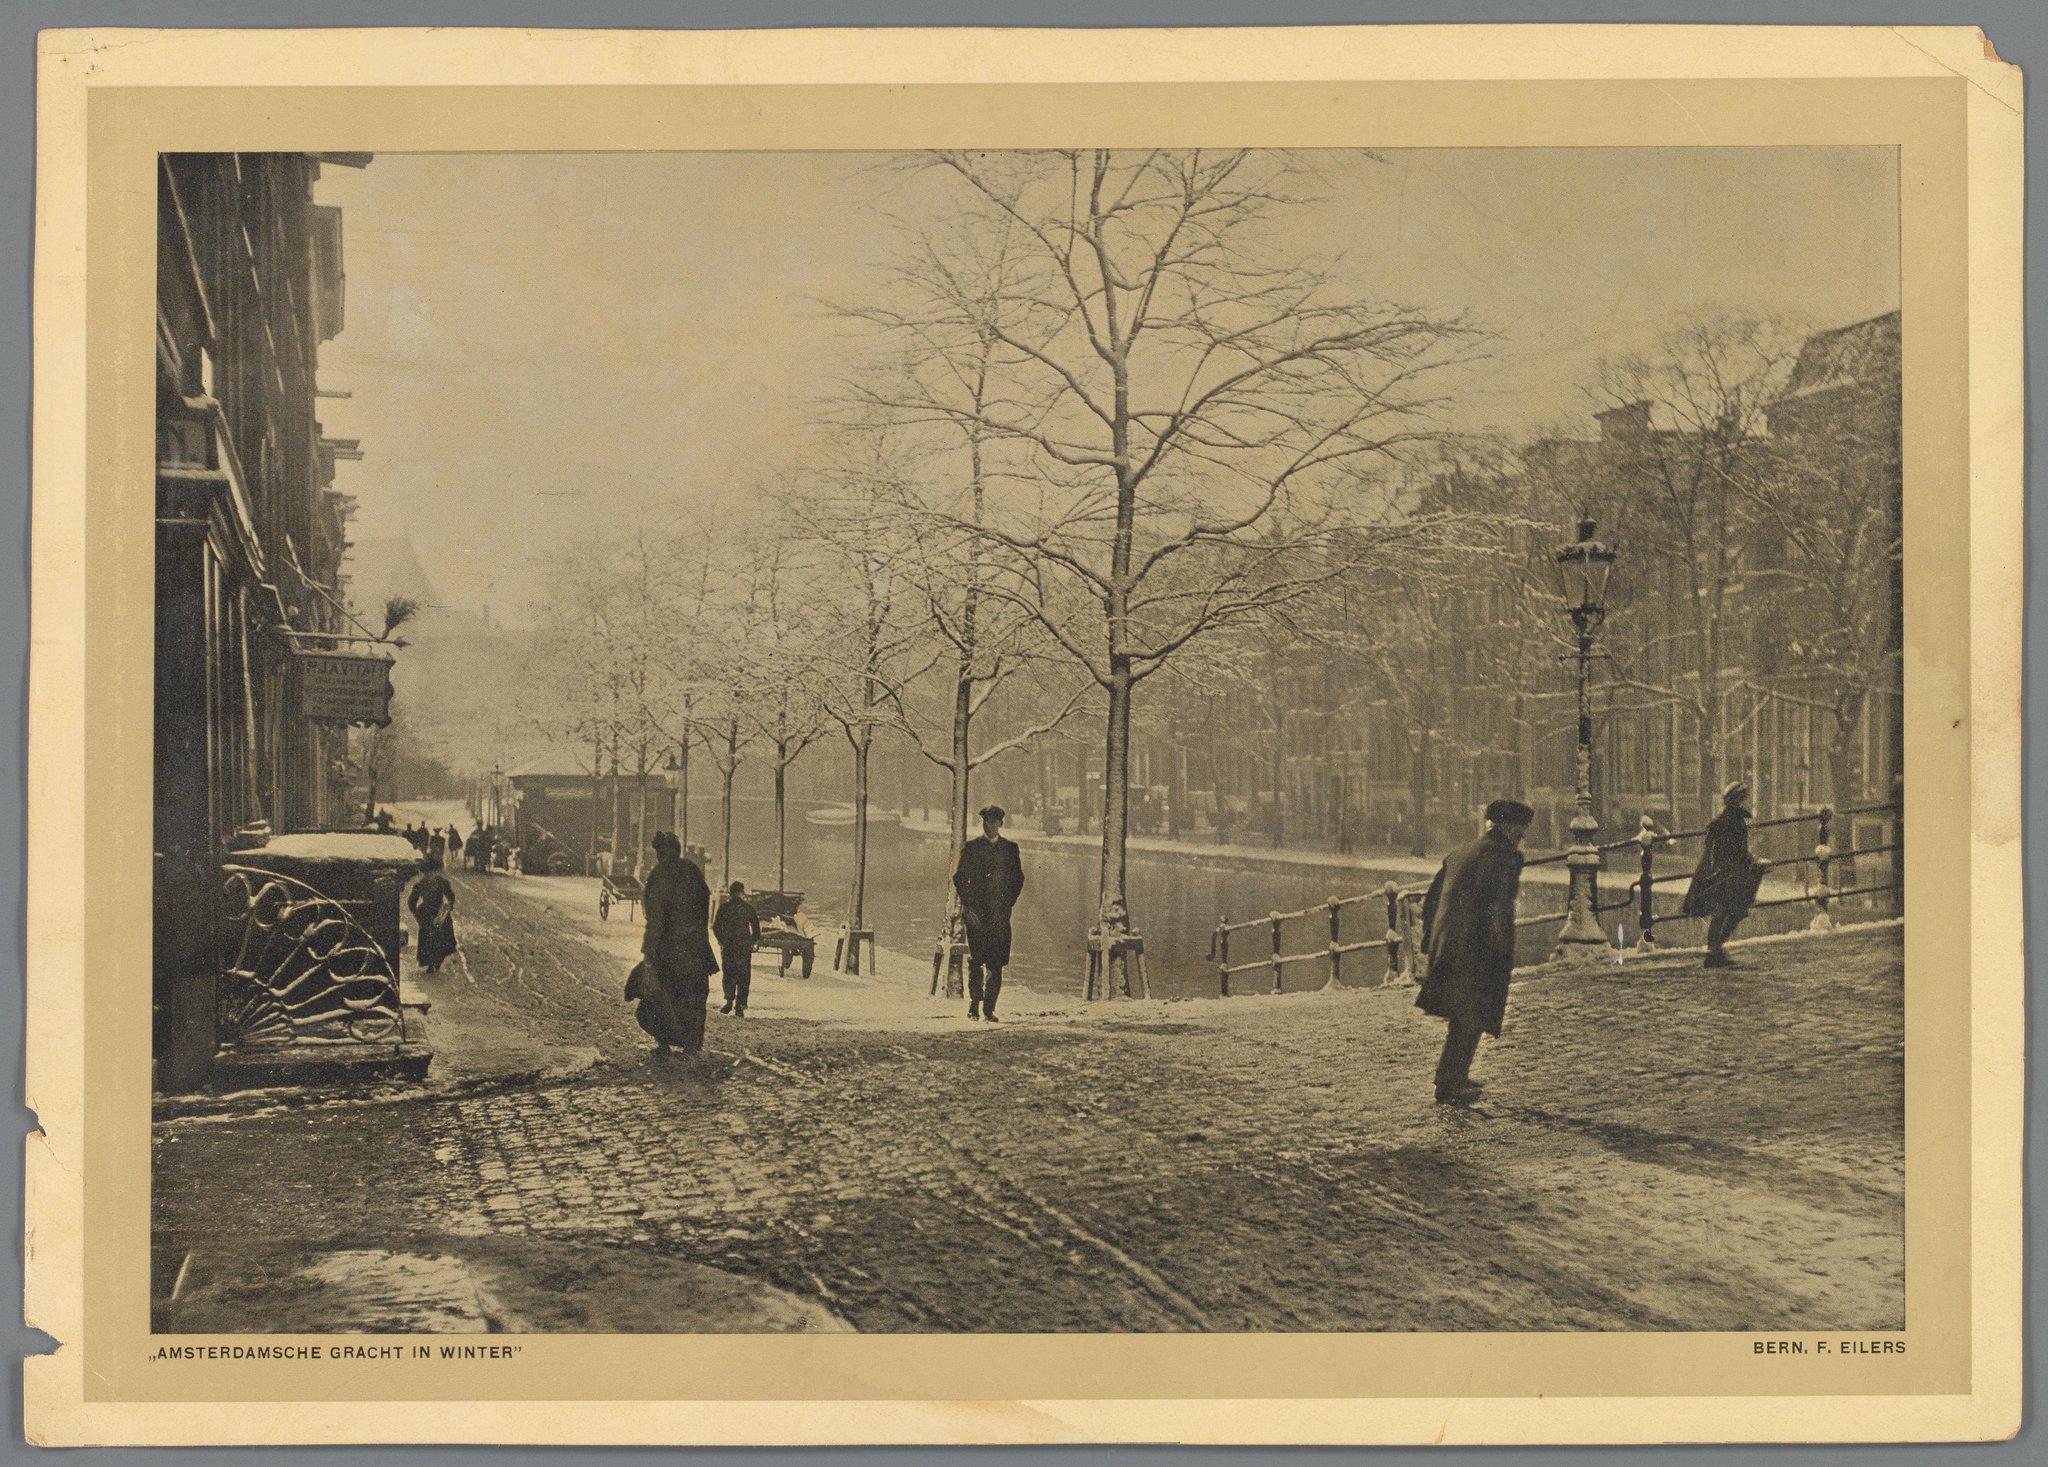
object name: photomechanical print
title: Gezicht op een Amsterdamse gracht in de winter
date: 1891-1951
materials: paper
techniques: autotype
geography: amsterdam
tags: urban housing, snow, canals, waters (in city) (+ city(-scape) with figures, staffage), amsterdam